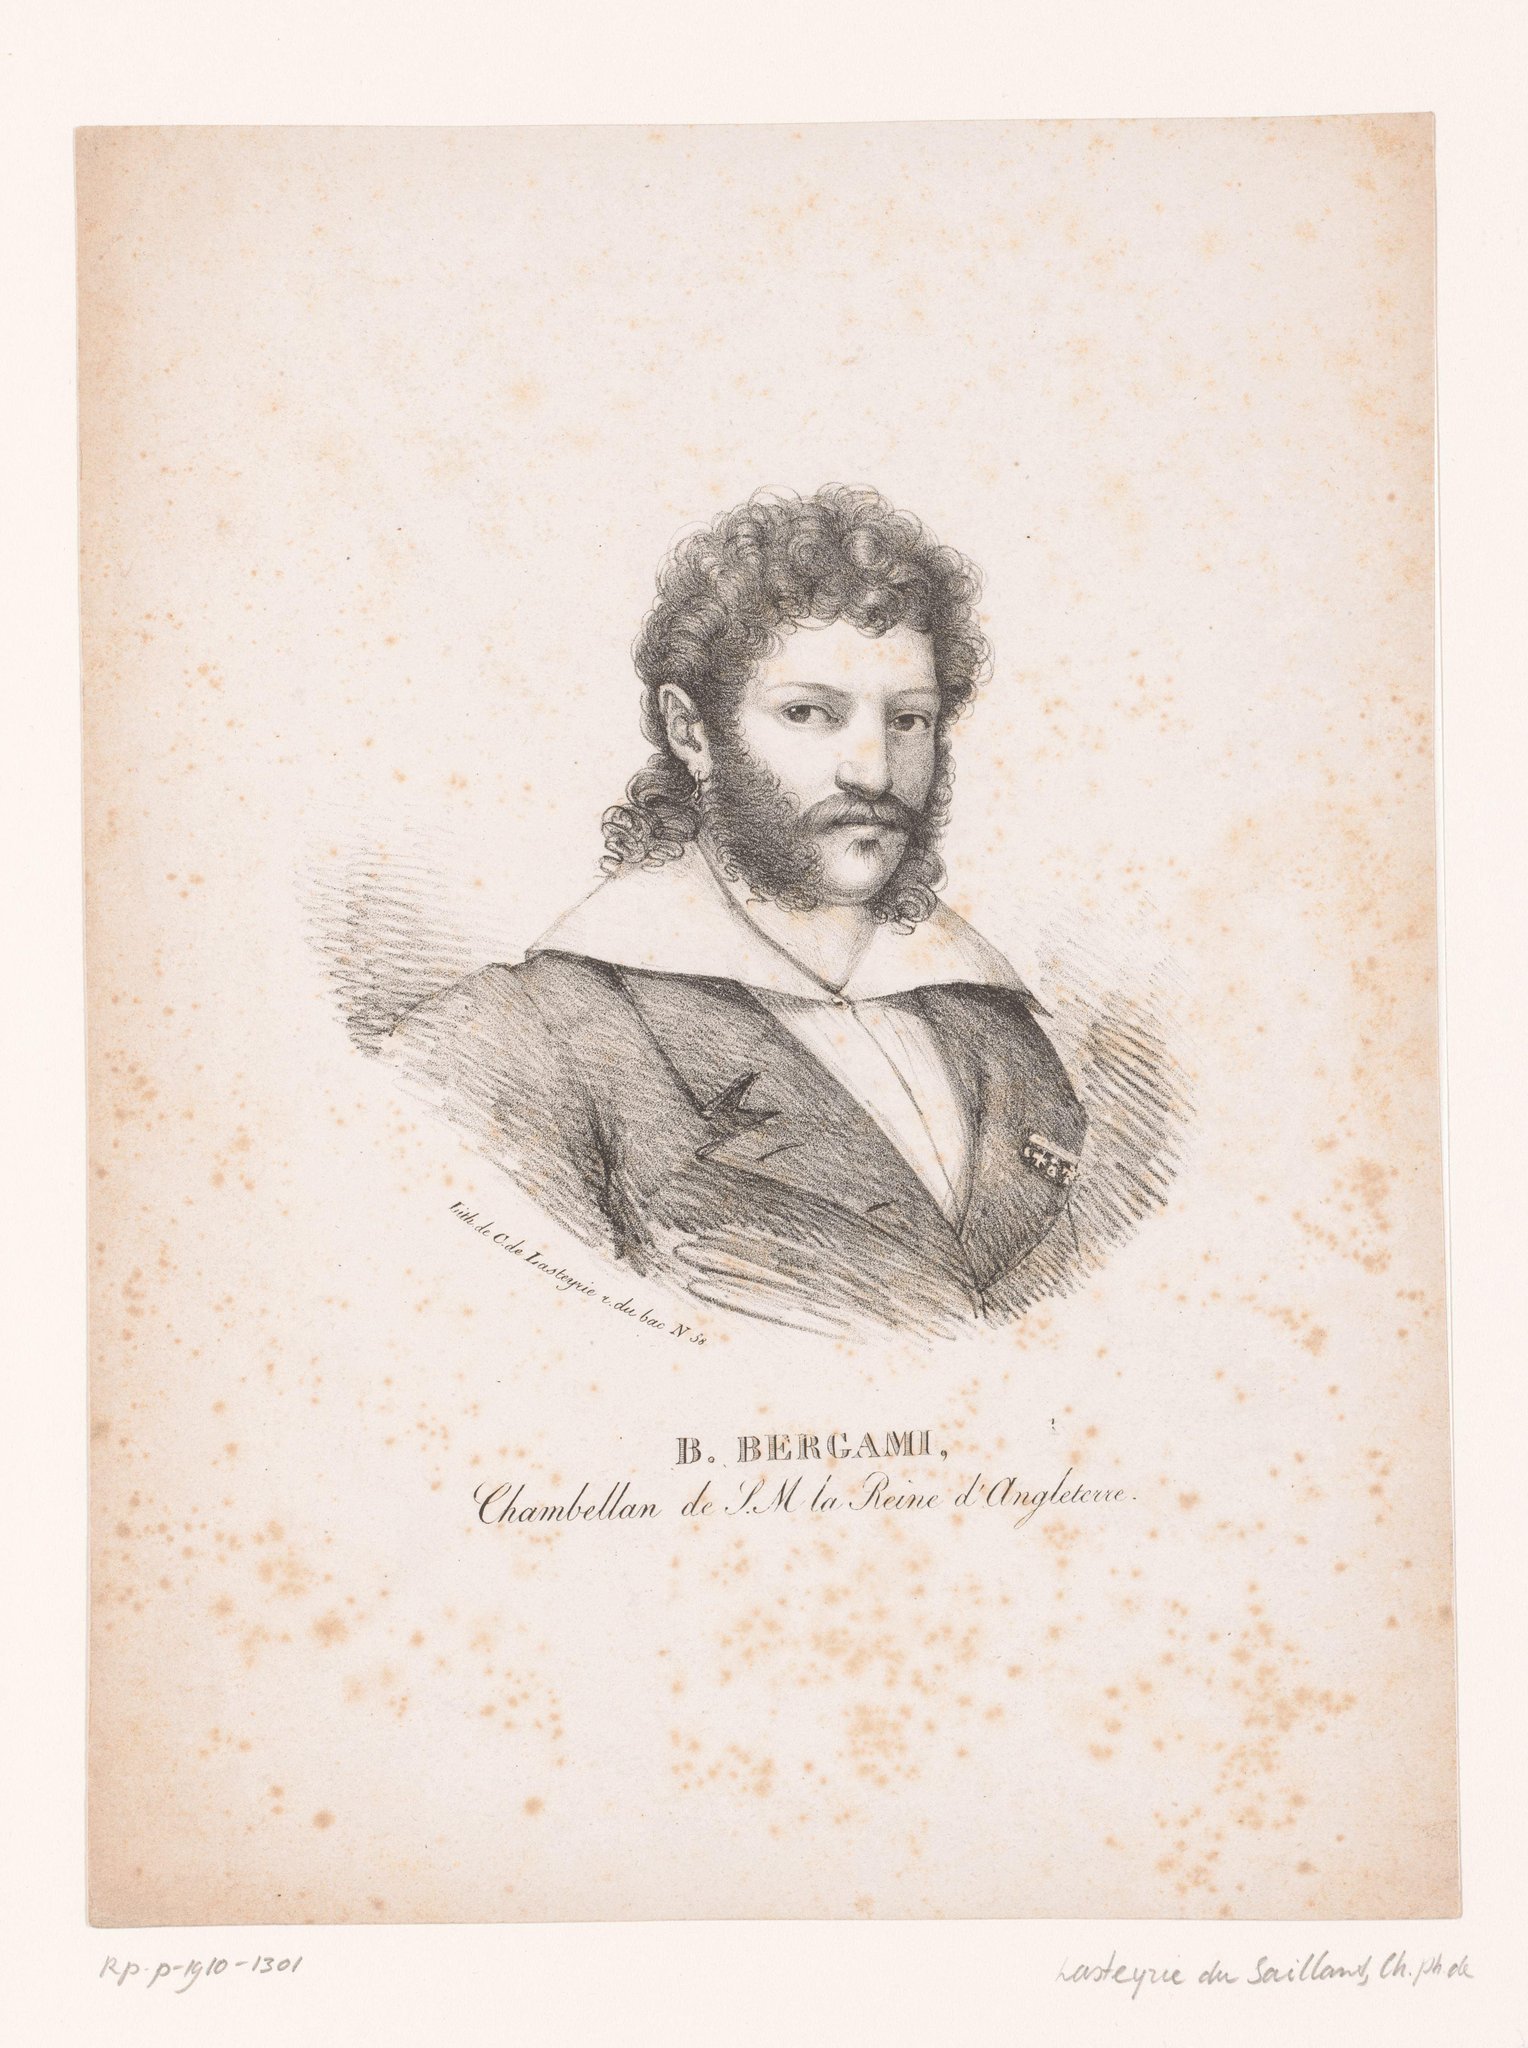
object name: print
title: D. Bergami, Chambellan de P.M. la Reine d'Angleterre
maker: charles philibert de lasteyrie du saillant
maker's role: print maker, printer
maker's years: 1759-1849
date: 1820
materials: paper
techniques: lithograph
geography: paris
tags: earl, historical persons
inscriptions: collector's mark: Lugt 2228a